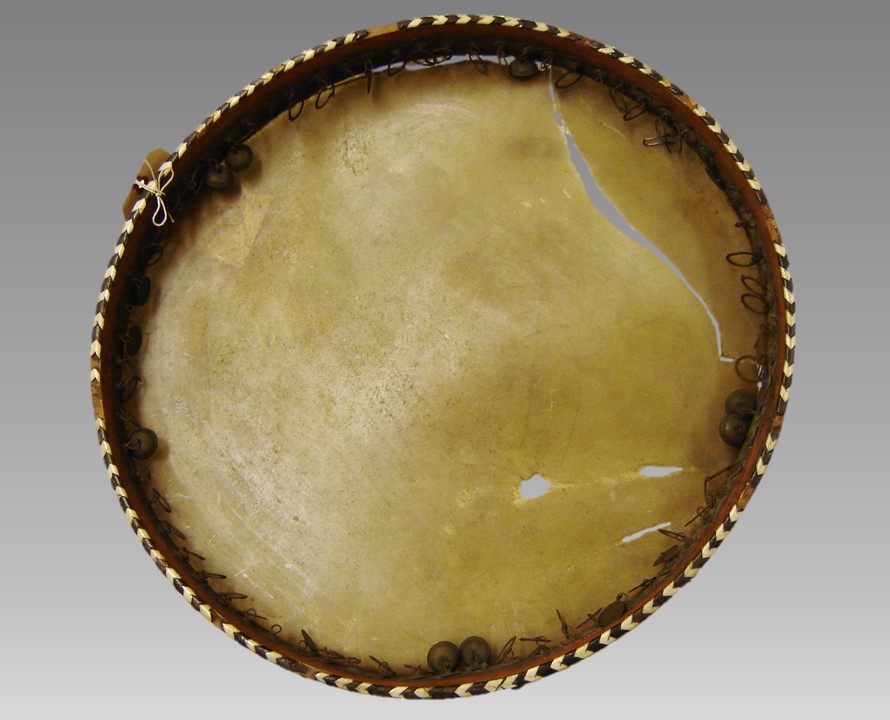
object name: daf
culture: azerbaijani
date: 1867-1900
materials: bone, leather, metal, skin, wood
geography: azerbaijan